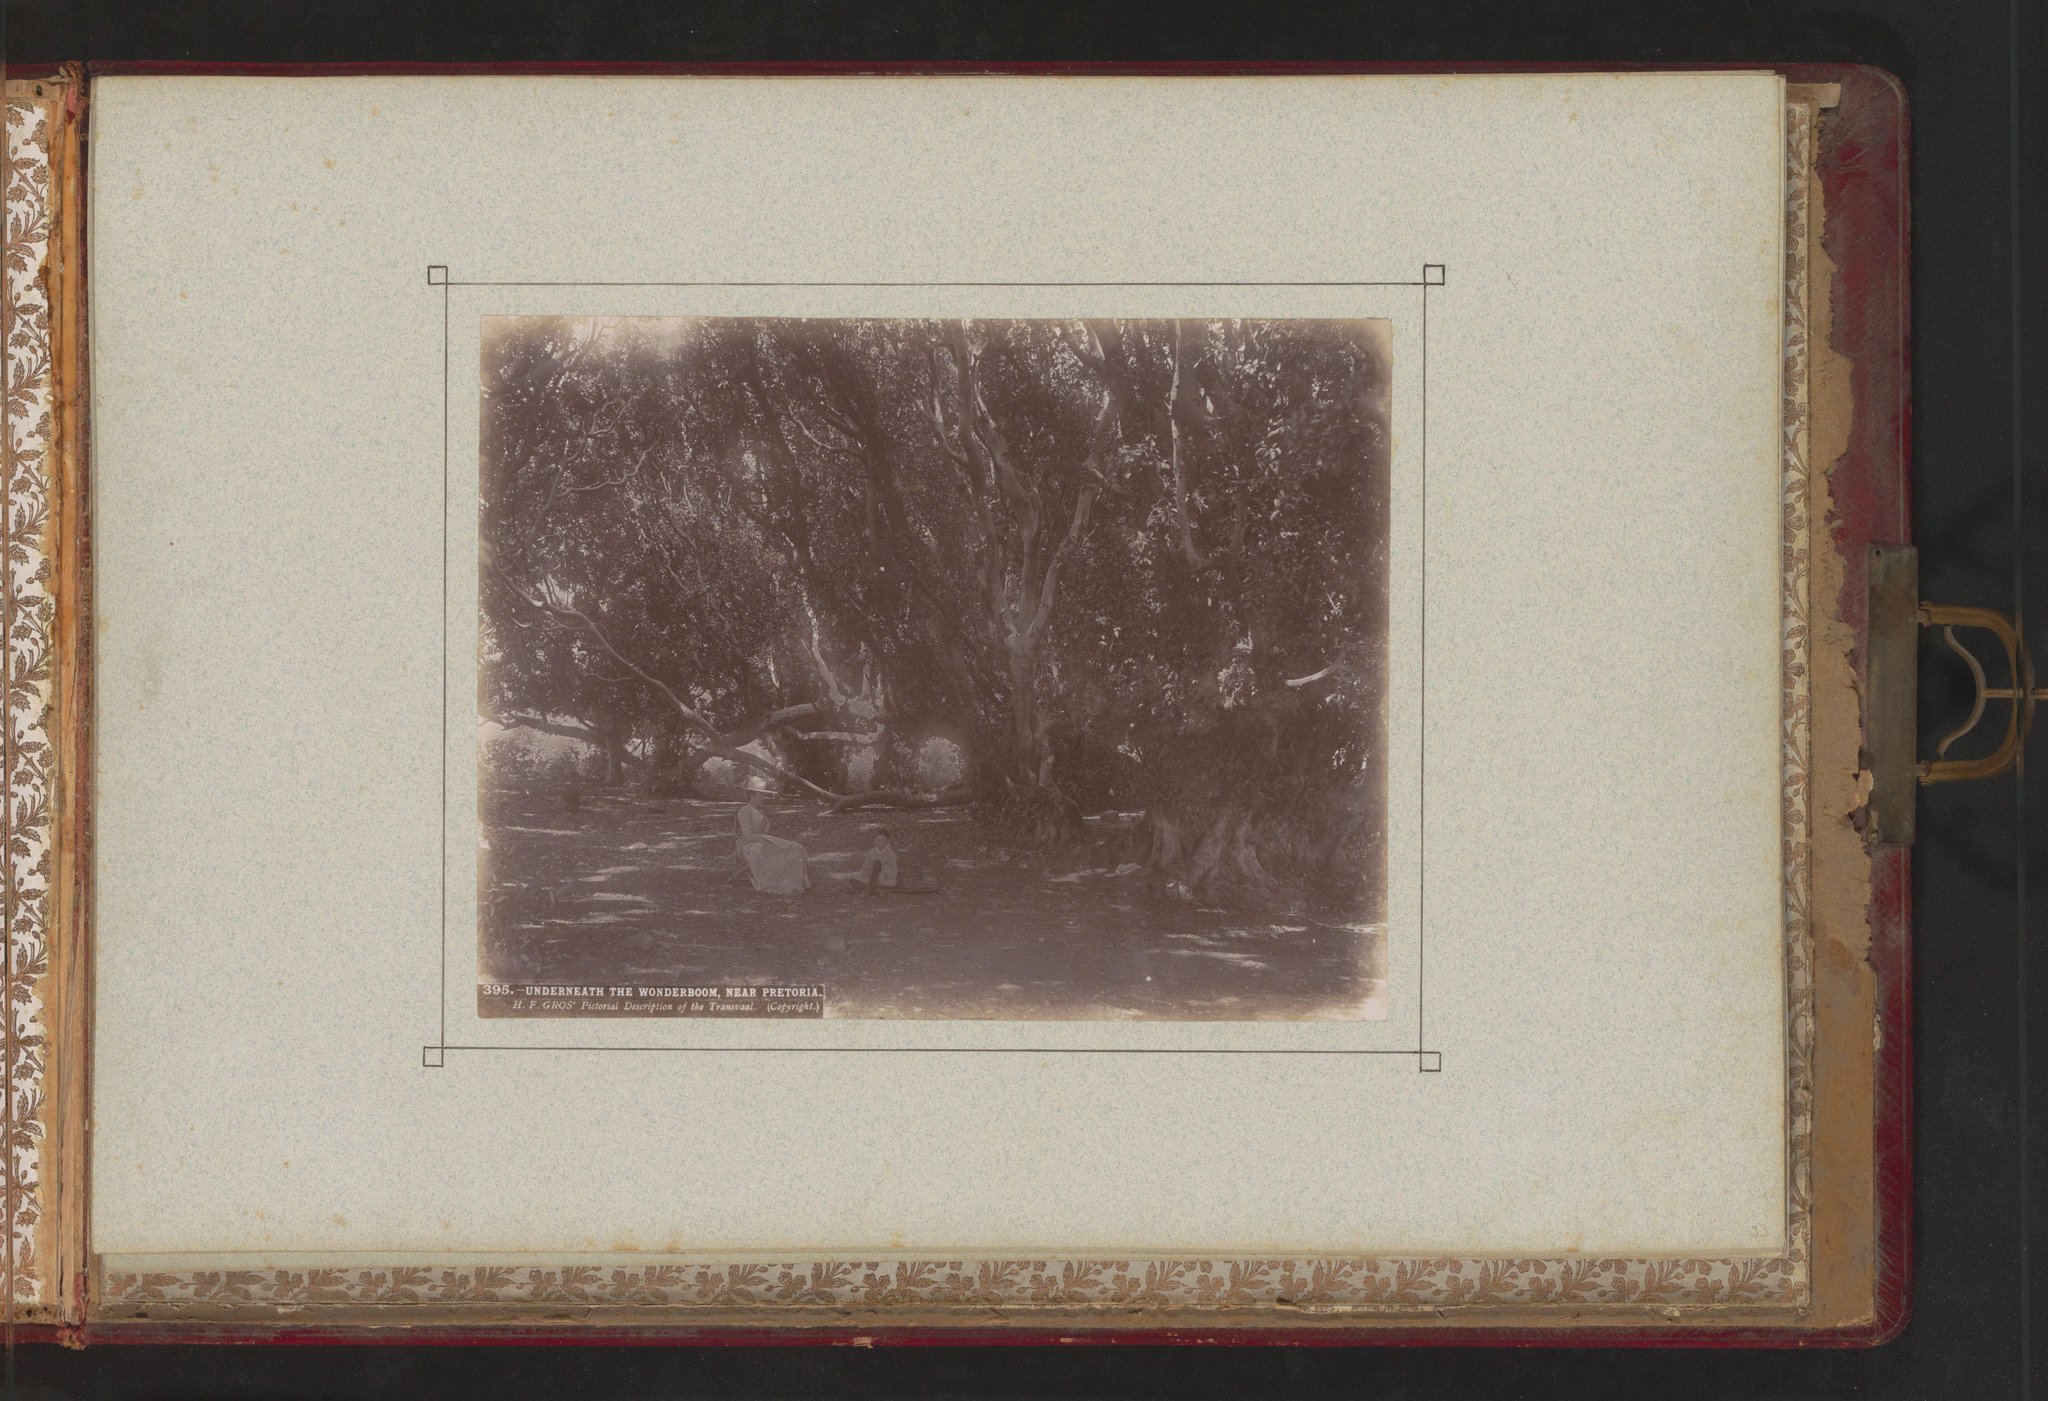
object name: photograph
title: Vrouw met kind zittend onder de Wonderboom bij Pretoria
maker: henri ferdinand gros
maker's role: fotograaf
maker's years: 1842-1915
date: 1880-1900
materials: photographic support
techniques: albumen print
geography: pretoria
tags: trees, mother and baby or young child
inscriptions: number: ‘395’, inscription: ‘H.F. Gros' Pictorial Description of the Transvaal. (Copyright.)’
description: Onderdeel van Reisalbum met foto's van Zuid-Afrika, Madeira, Portugal, Frankrijk en Duitsland.